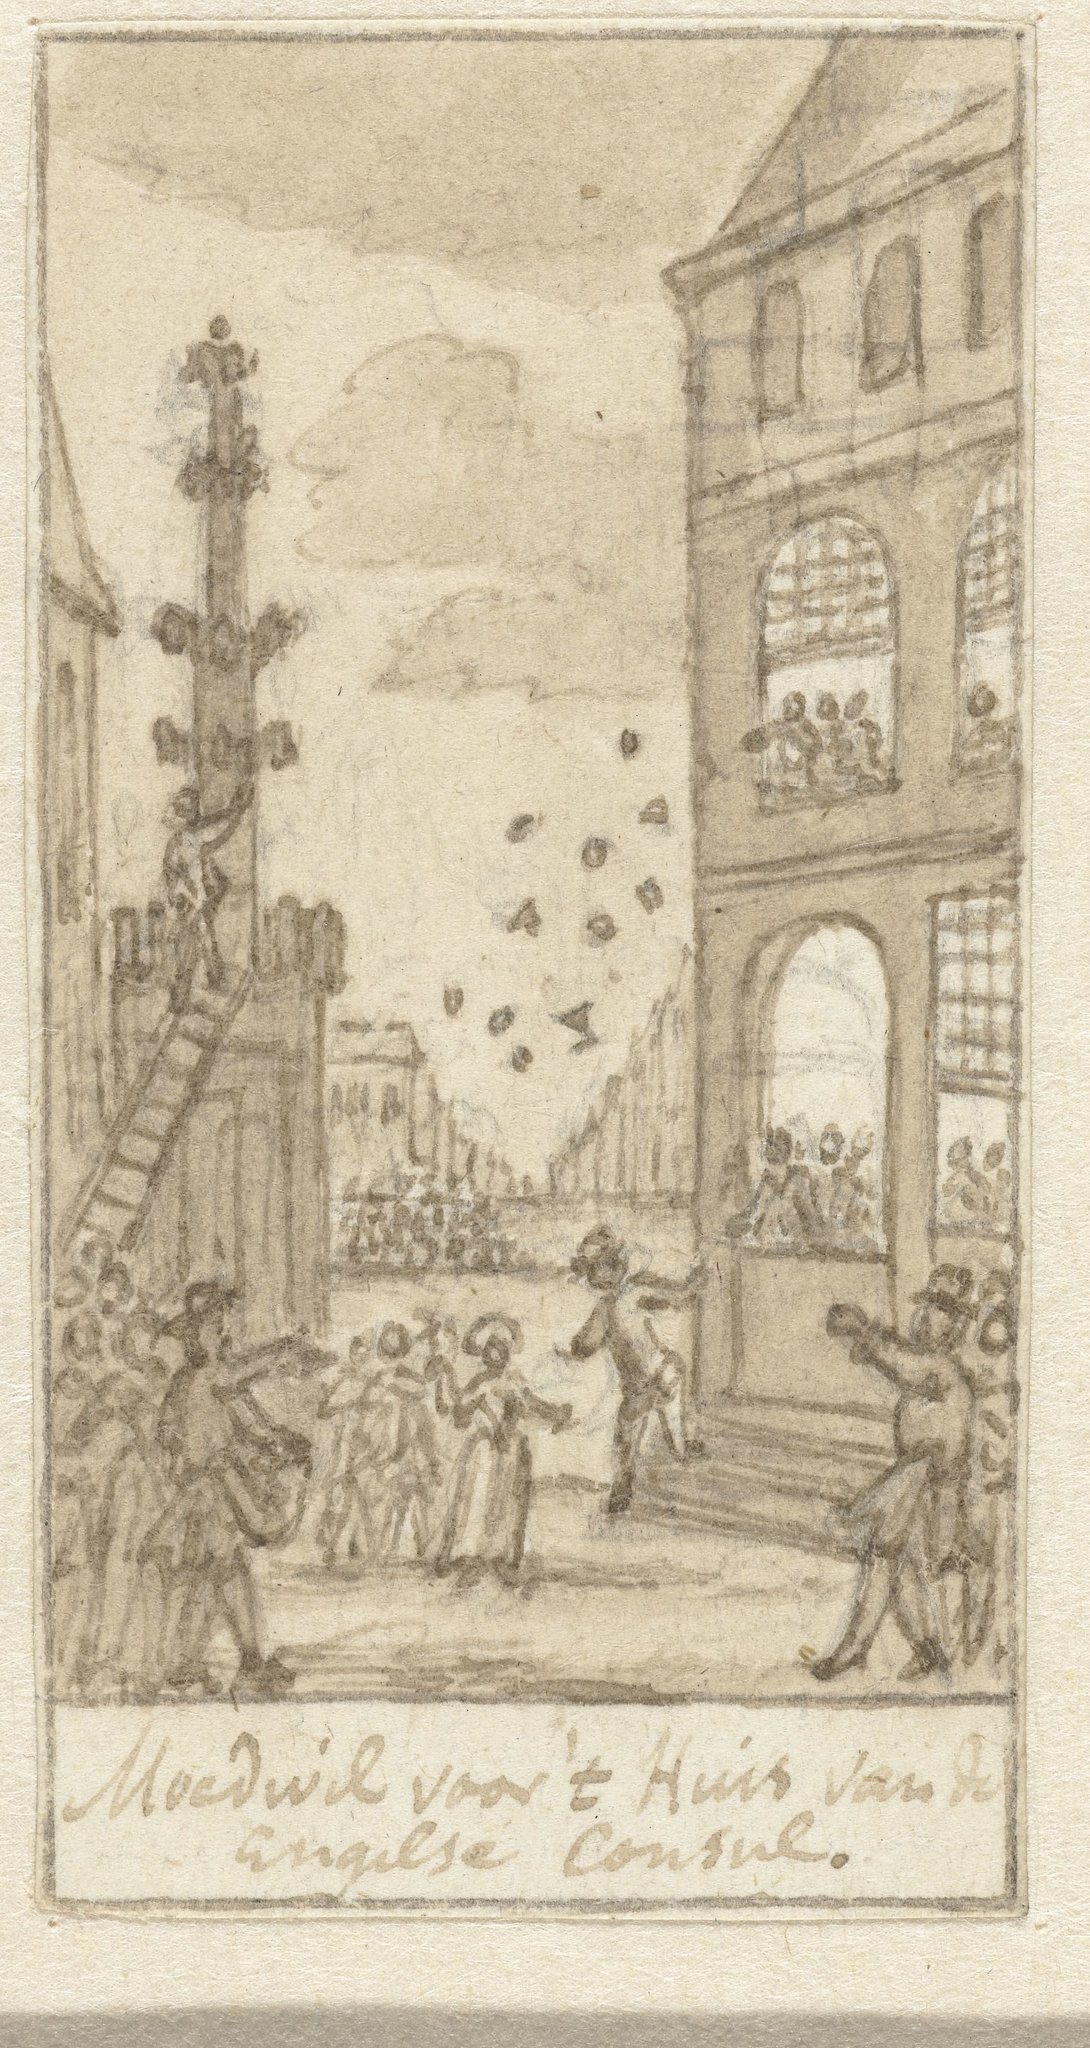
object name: drawing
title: Relletjes voor het huis van de Engelse consul te Amsterdam, 1688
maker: simon fokke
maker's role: draughtsman, print maker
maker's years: 1712-1784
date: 1777-1781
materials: paper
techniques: pouncing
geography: northern netherlands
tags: london, rome, street-fights, riots, historical events and situations, amsterdam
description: Ontwerptekening voor illustratie in: Jacobus Kok, Amsteldamsche jaarboeken, behelzende de merkwaardigste geschiedenissen, welken, zo binnen de stad als daaromtrent, zijn voorgevallen, sedert haare eerste beginselen, tot op den tegenwoordigen tijd ... / Bijeengebragt door Jacobus Kok, 3 dln., J.B. Elwe, Amsterdam 1781.